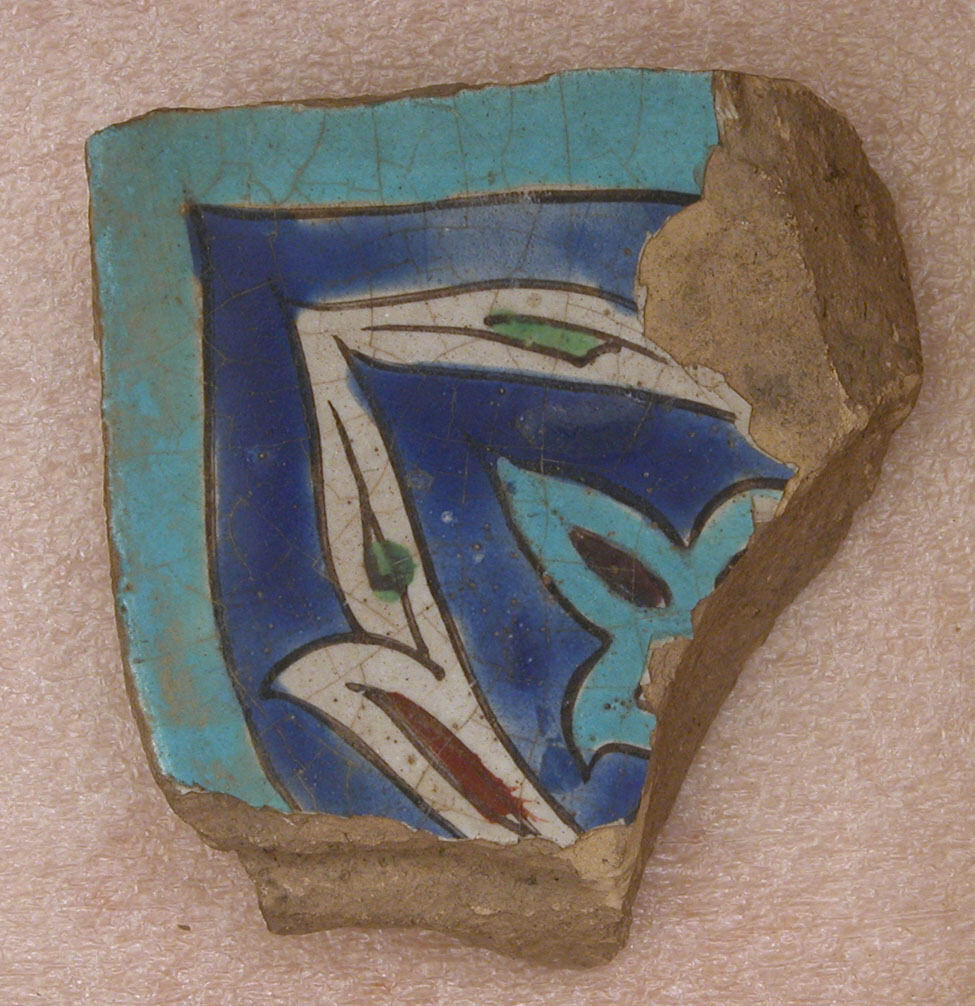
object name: tile fragment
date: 1334-1434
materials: glaze, stonepaste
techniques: painting, polychrome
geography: uzbekistan